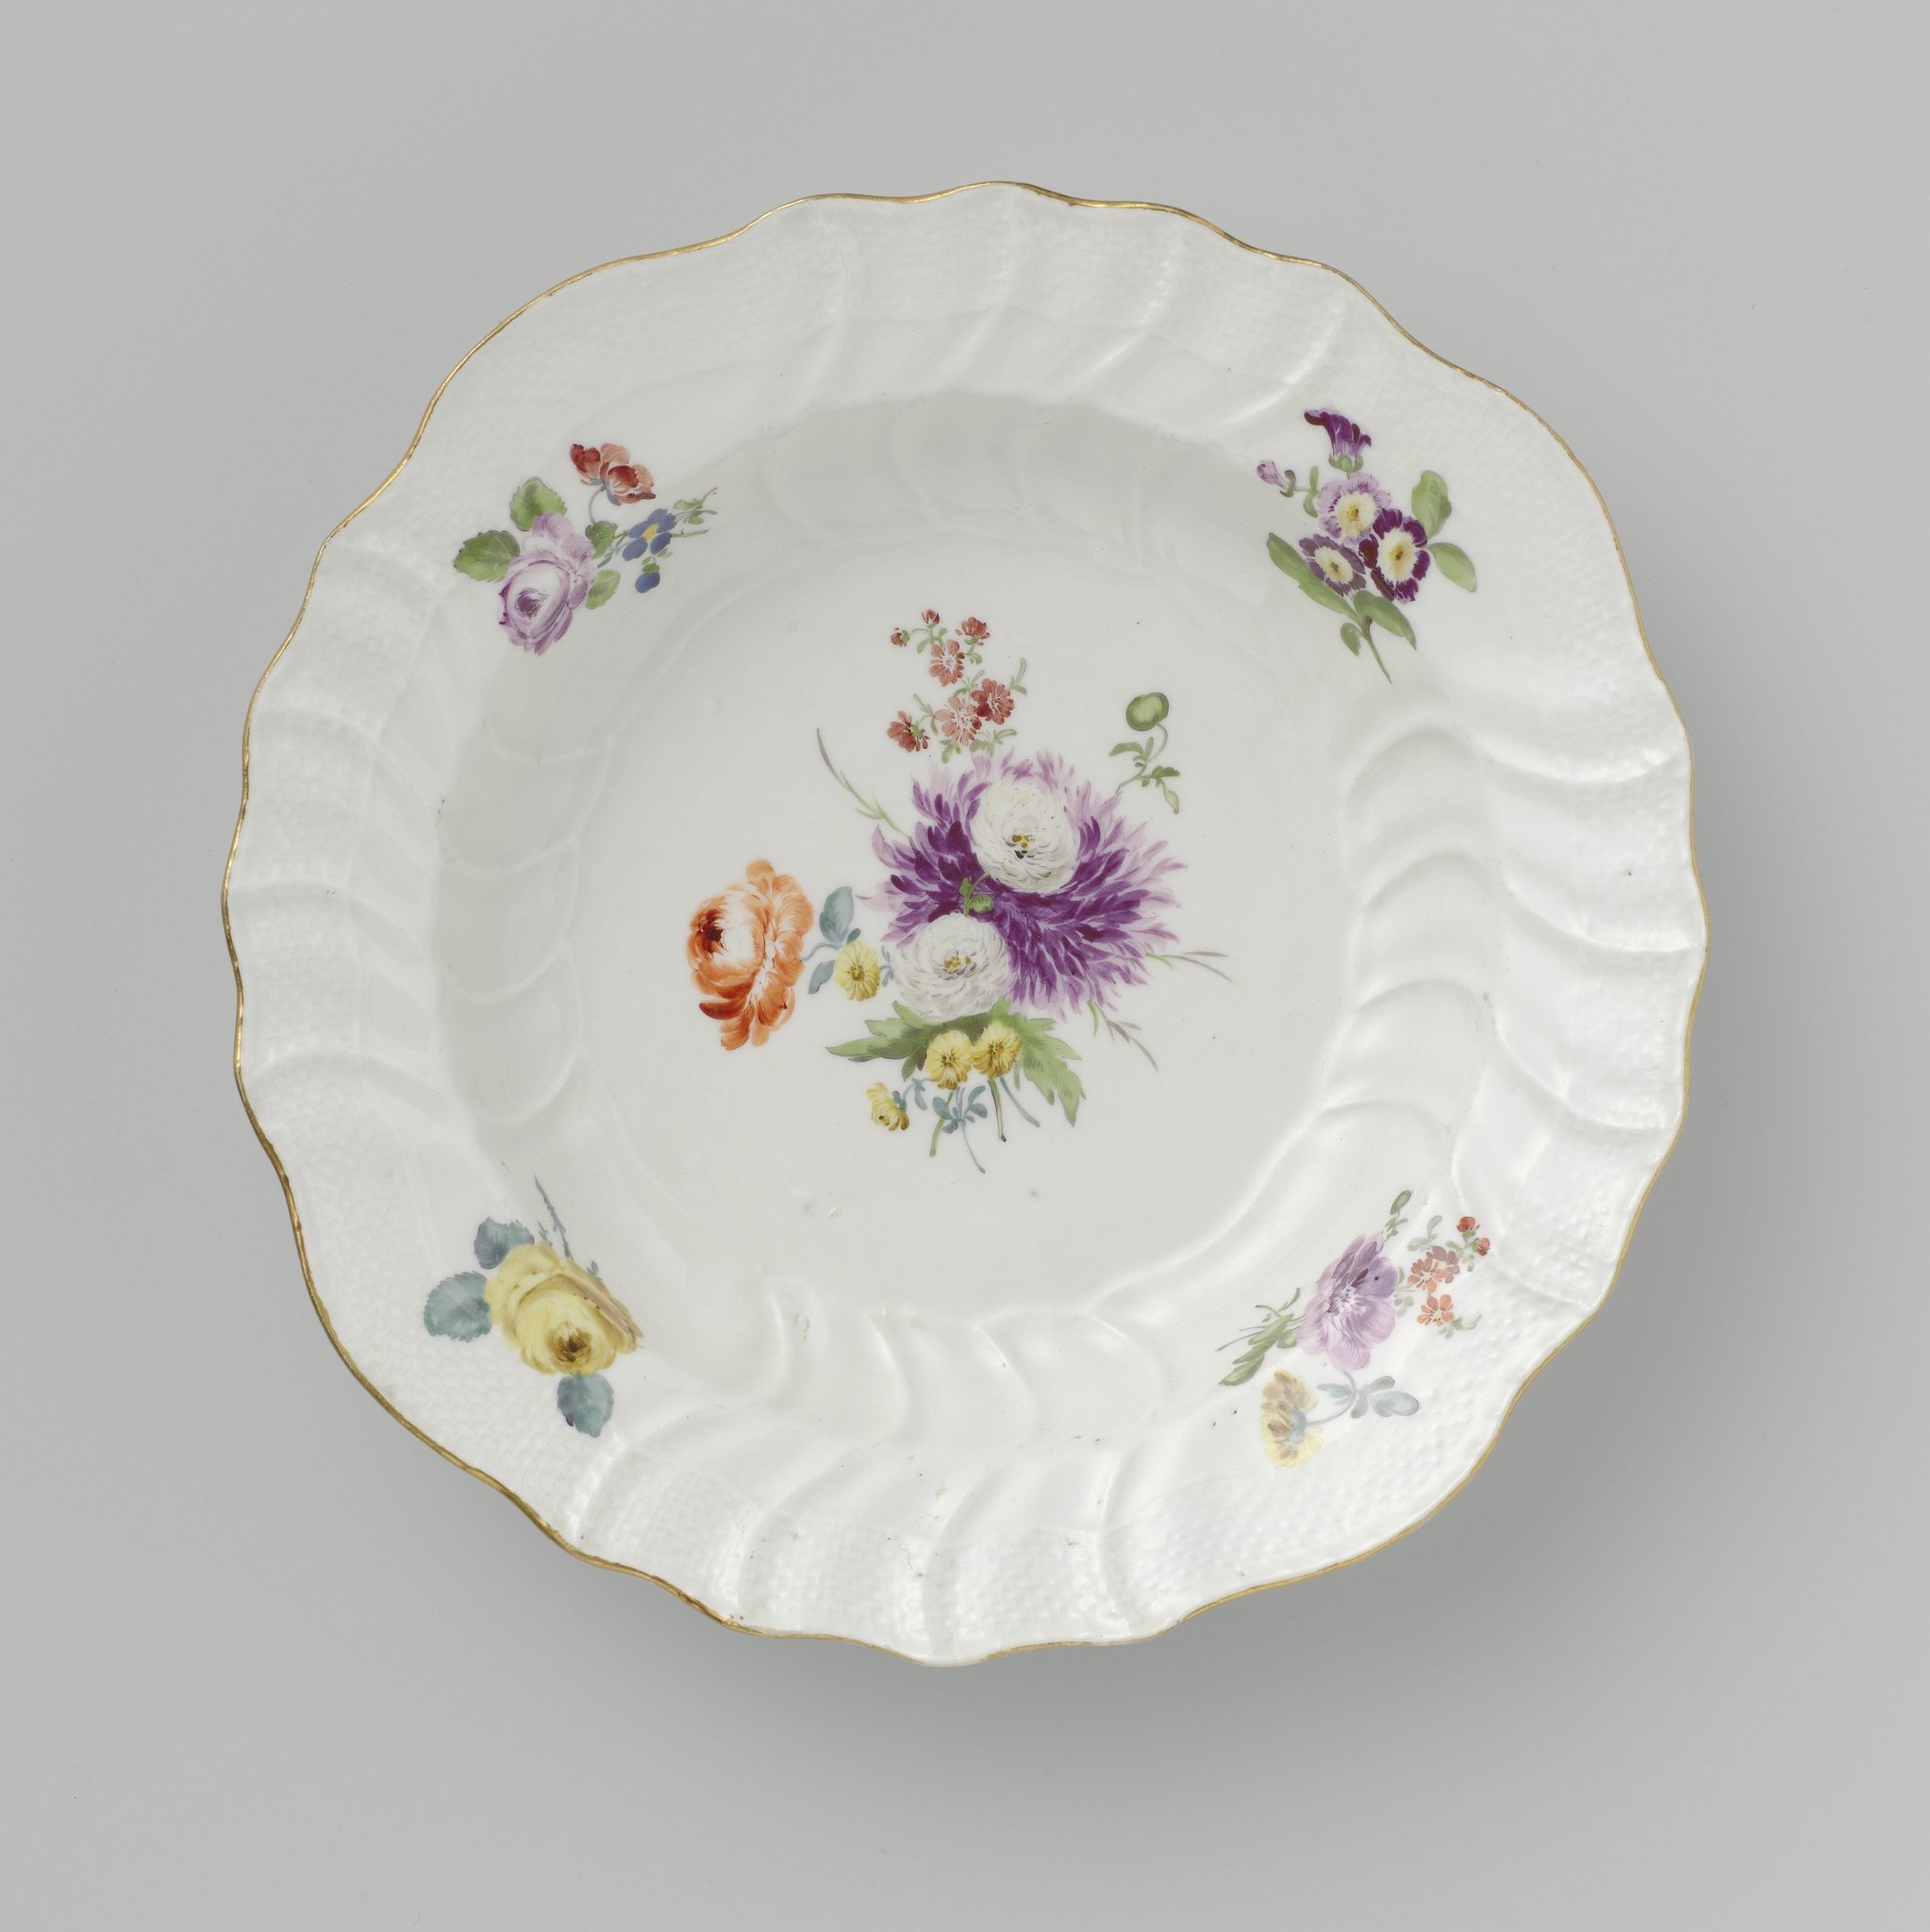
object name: eating drinking utensil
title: Bord, veelkleurig beschilderd met Deutsche Blumen, insekten en vruchten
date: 1750-1760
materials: porcelain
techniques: painted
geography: meissen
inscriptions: factory mark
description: Rond soepbord van beschilderd porselein. Het bord is beschilderd met Deutsche Blumen, insekten en vruchten. De rand is in reliëf versierd met het Neuozier-patroon. Het bord is gemerkt en hoort bij een servies (BK-17474-1 t/m BK-17474-253).